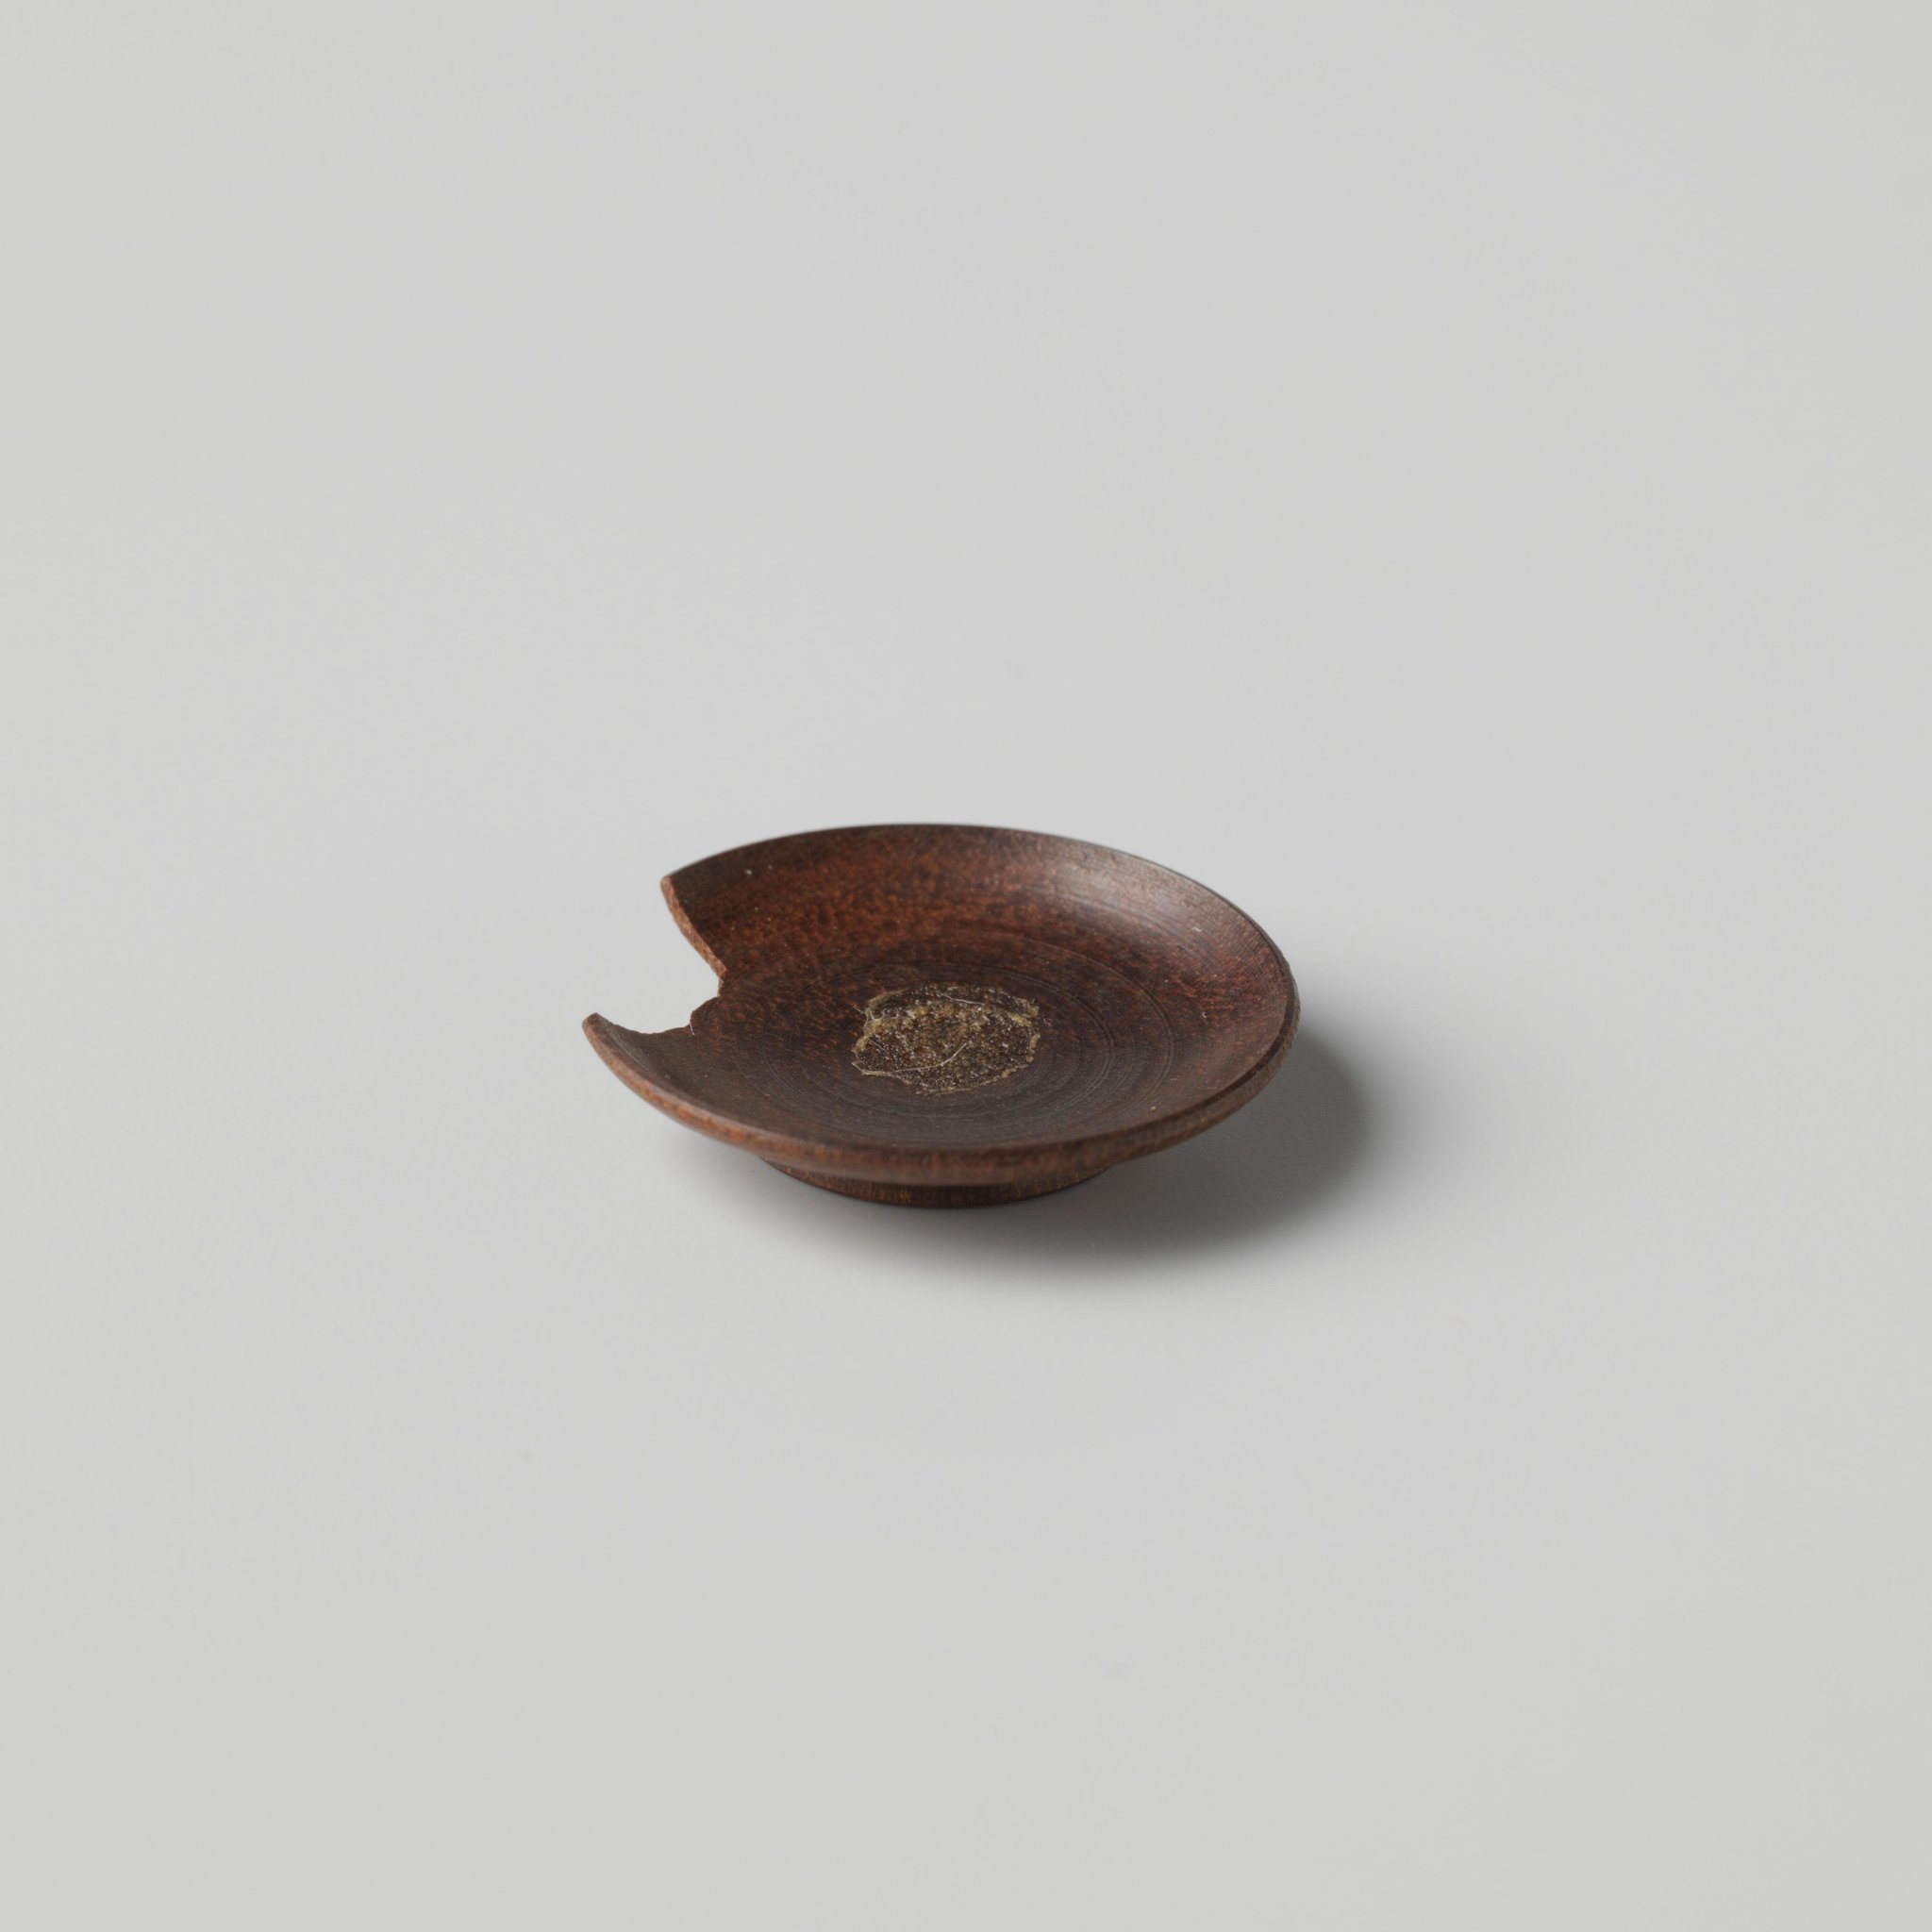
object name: platter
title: Schotel van gedraaid hout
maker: Anonymous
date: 1800-1899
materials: wood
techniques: tropisch hardhout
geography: england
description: Schotel zonder rand, gedraaid van een donkere hardhoutsoort.